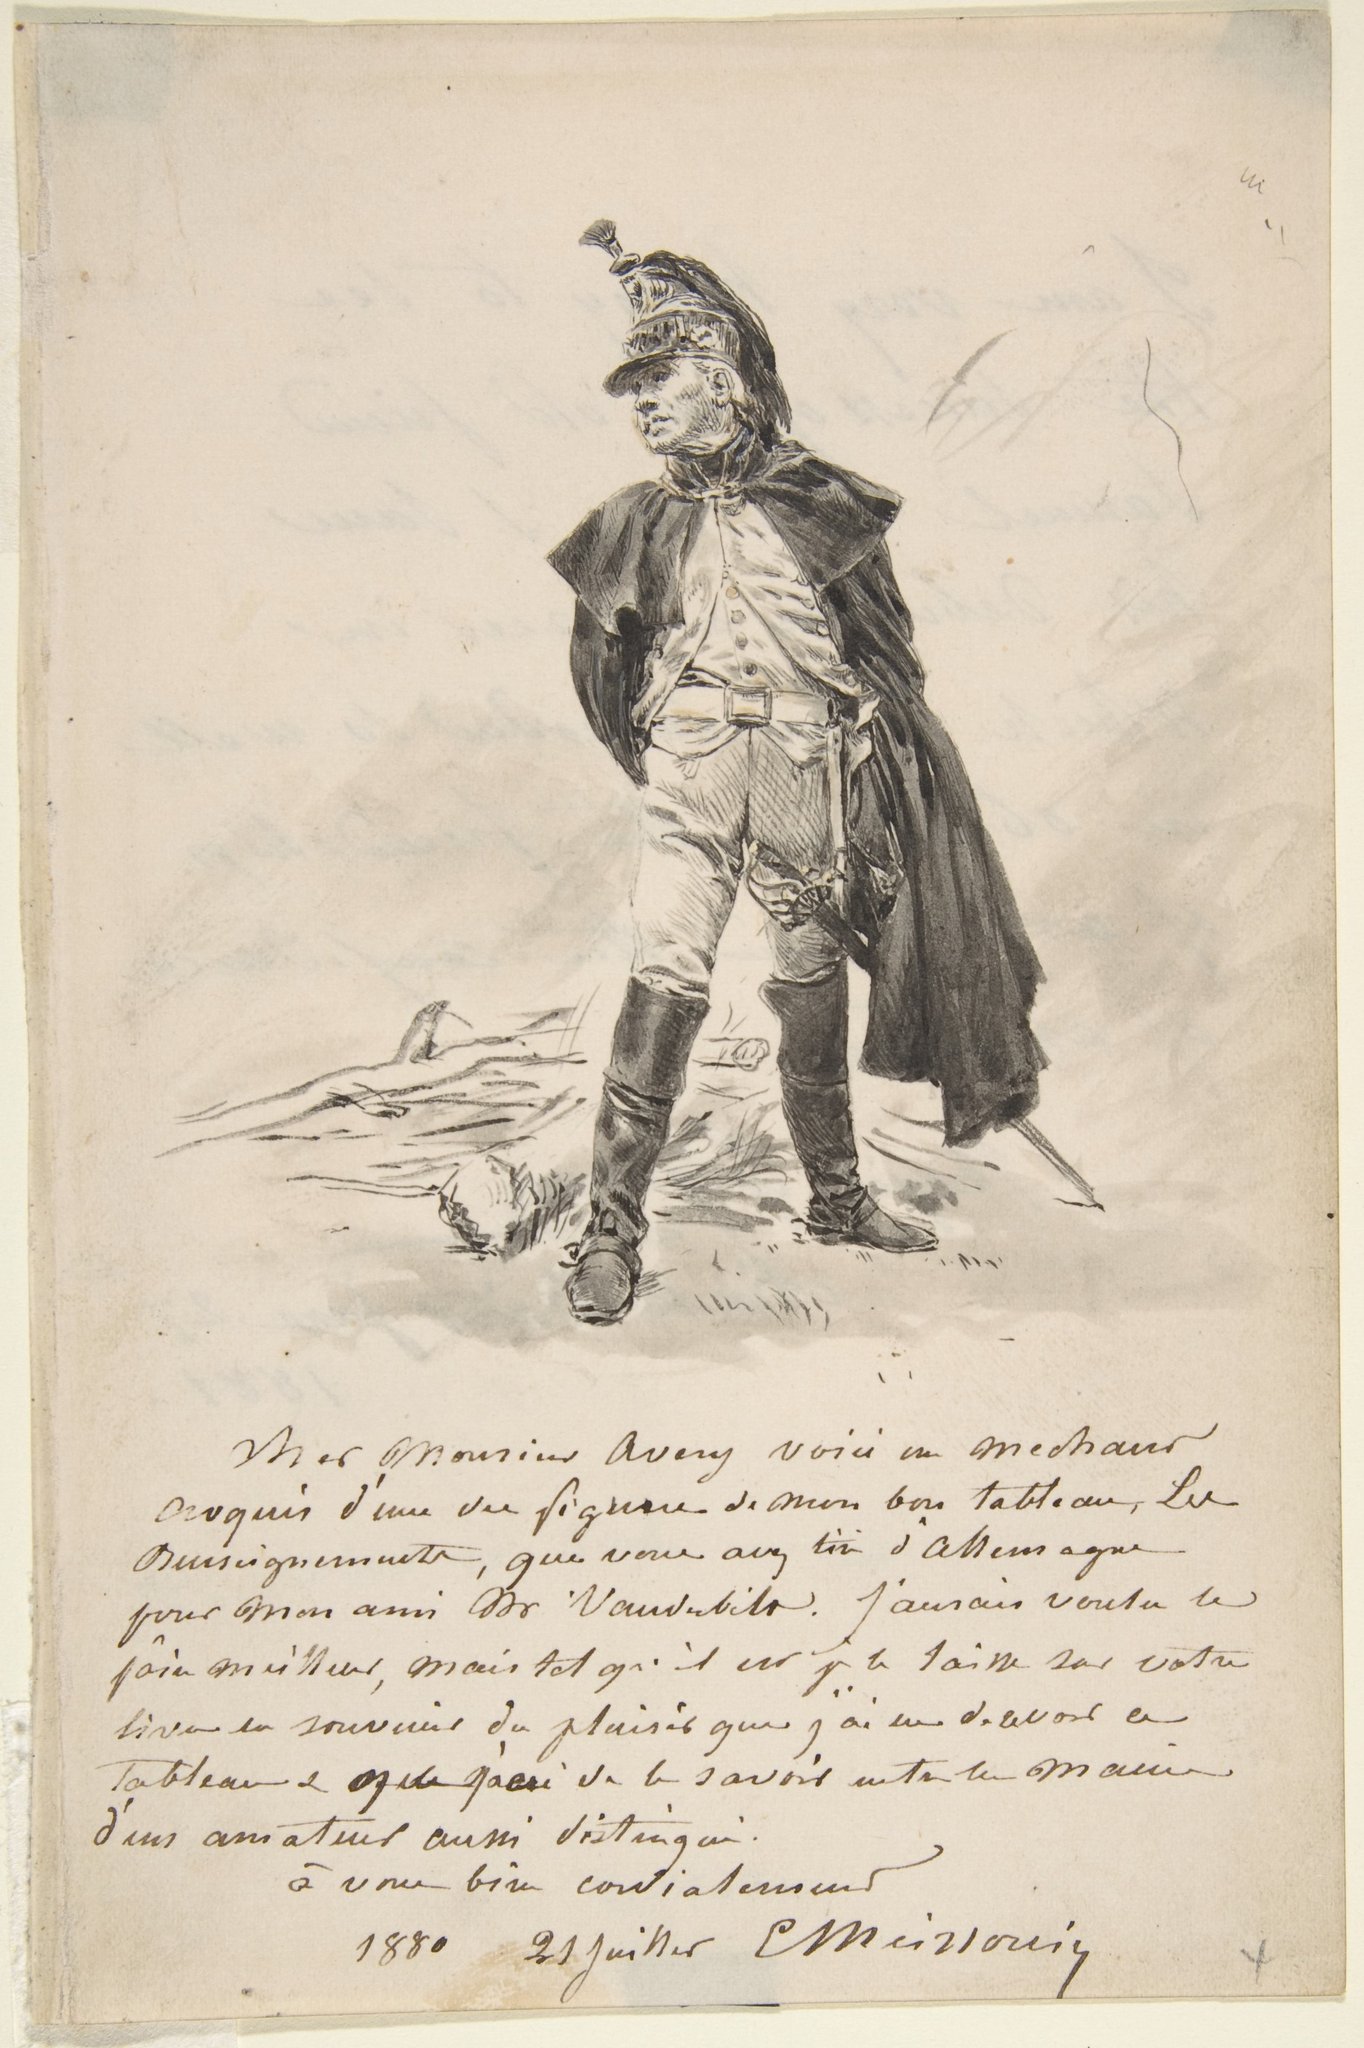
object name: drawing, letter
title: Letter to Samuel P. Avery with a drawing of a military figure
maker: ernest meissonier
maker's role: artist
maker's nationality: french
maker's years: 1815-1891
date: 1880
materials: gouache, ink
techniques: pen, wash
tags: military,men